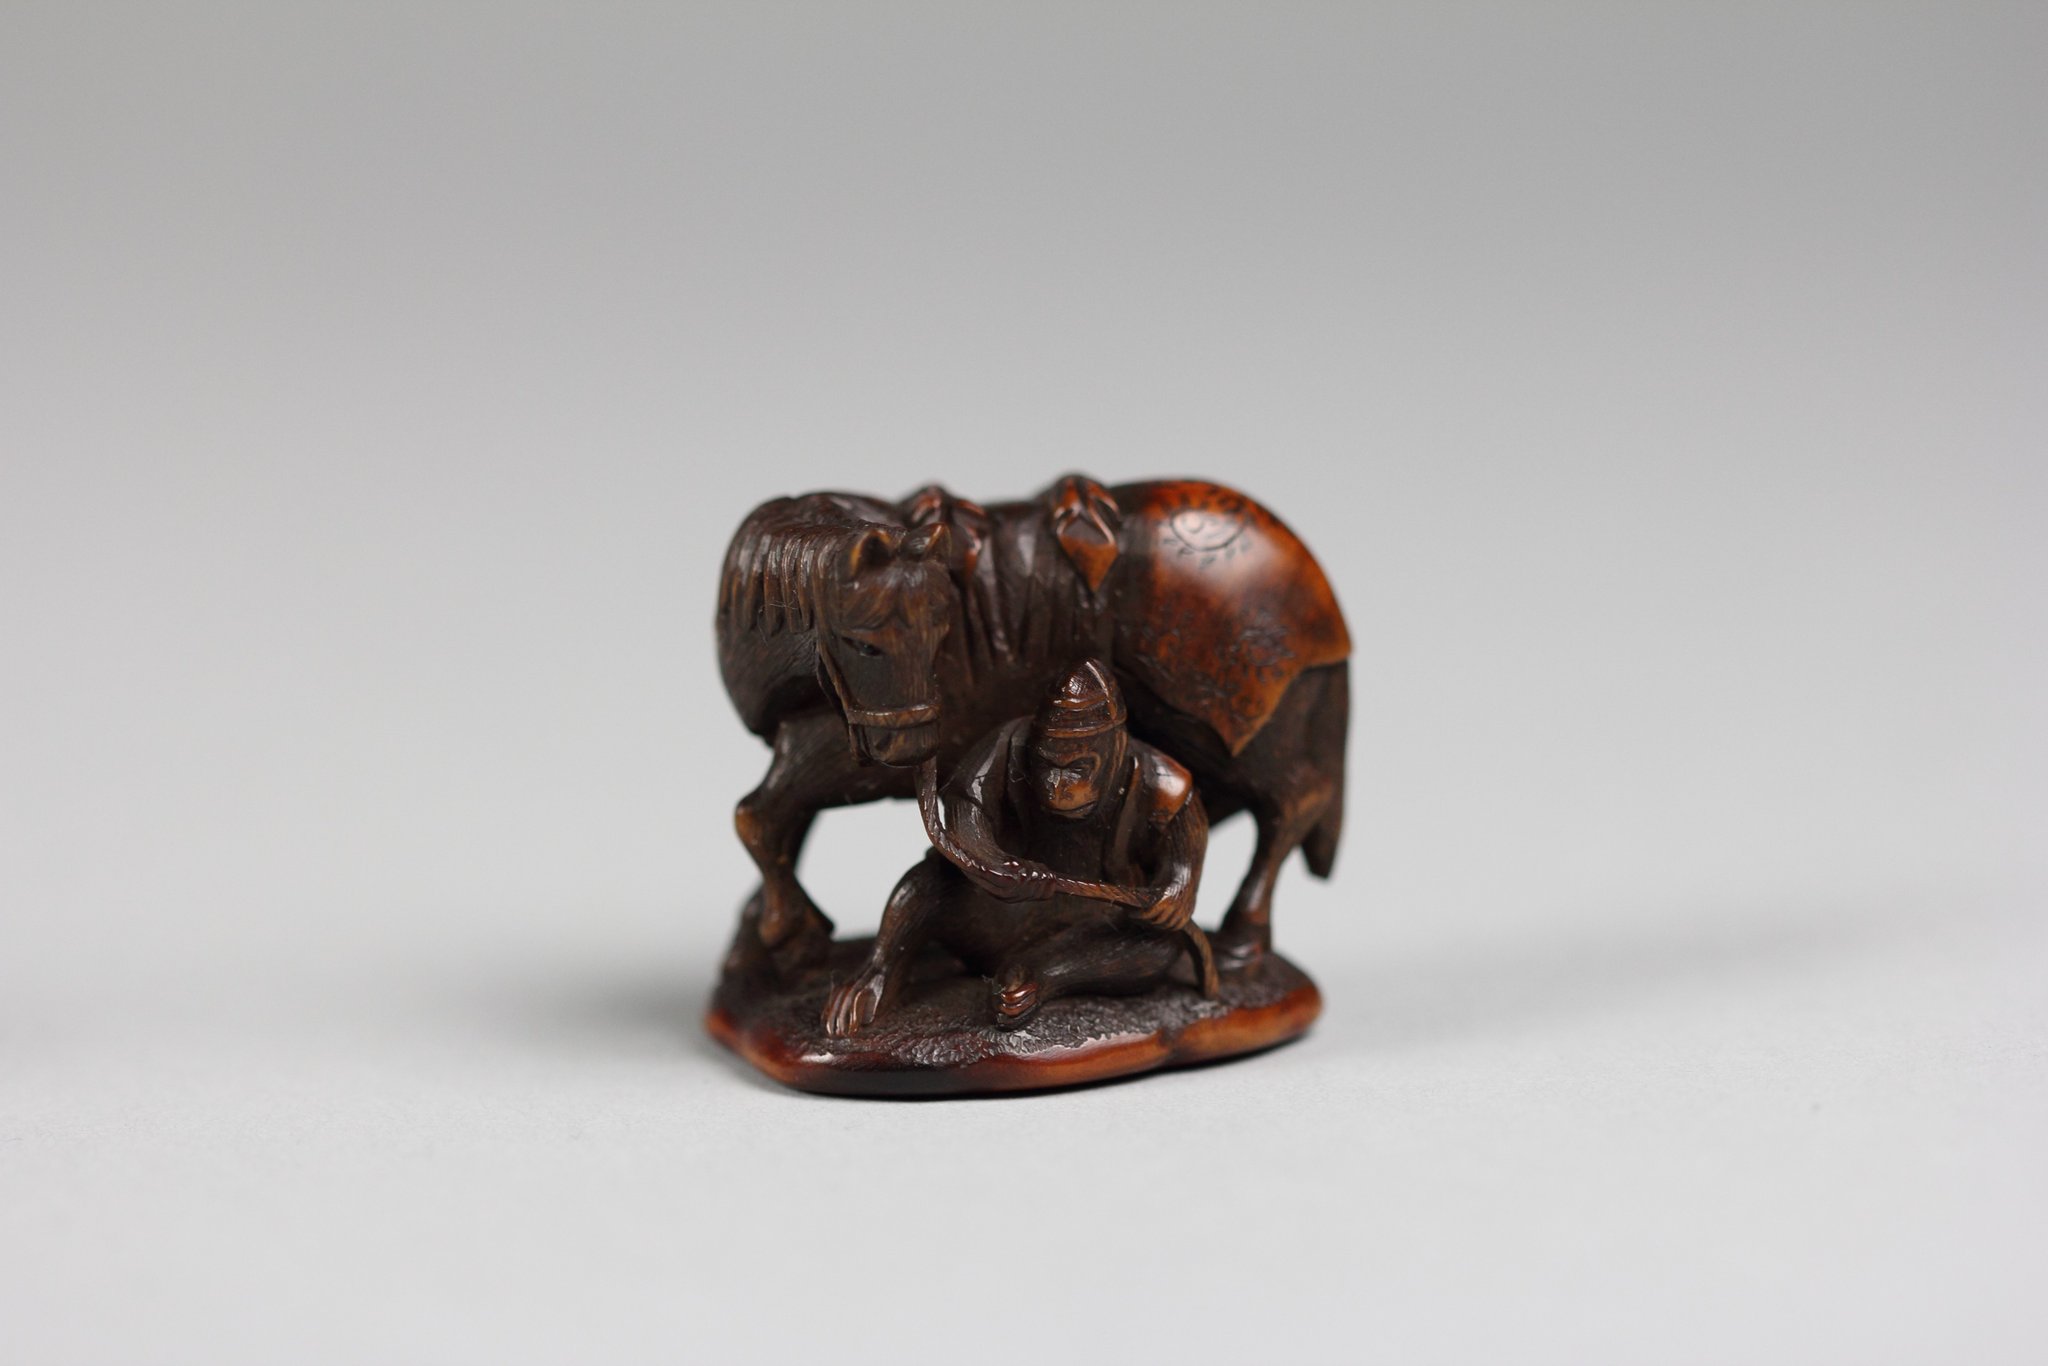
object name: netsuke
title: Netsuke of Monkey Holding Horse Rein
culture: japanese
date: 1801-1900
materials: wood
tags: horses